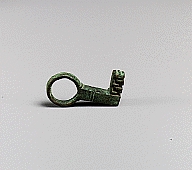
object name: key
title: Bronze ring key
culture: roman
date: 201-400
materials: bronze